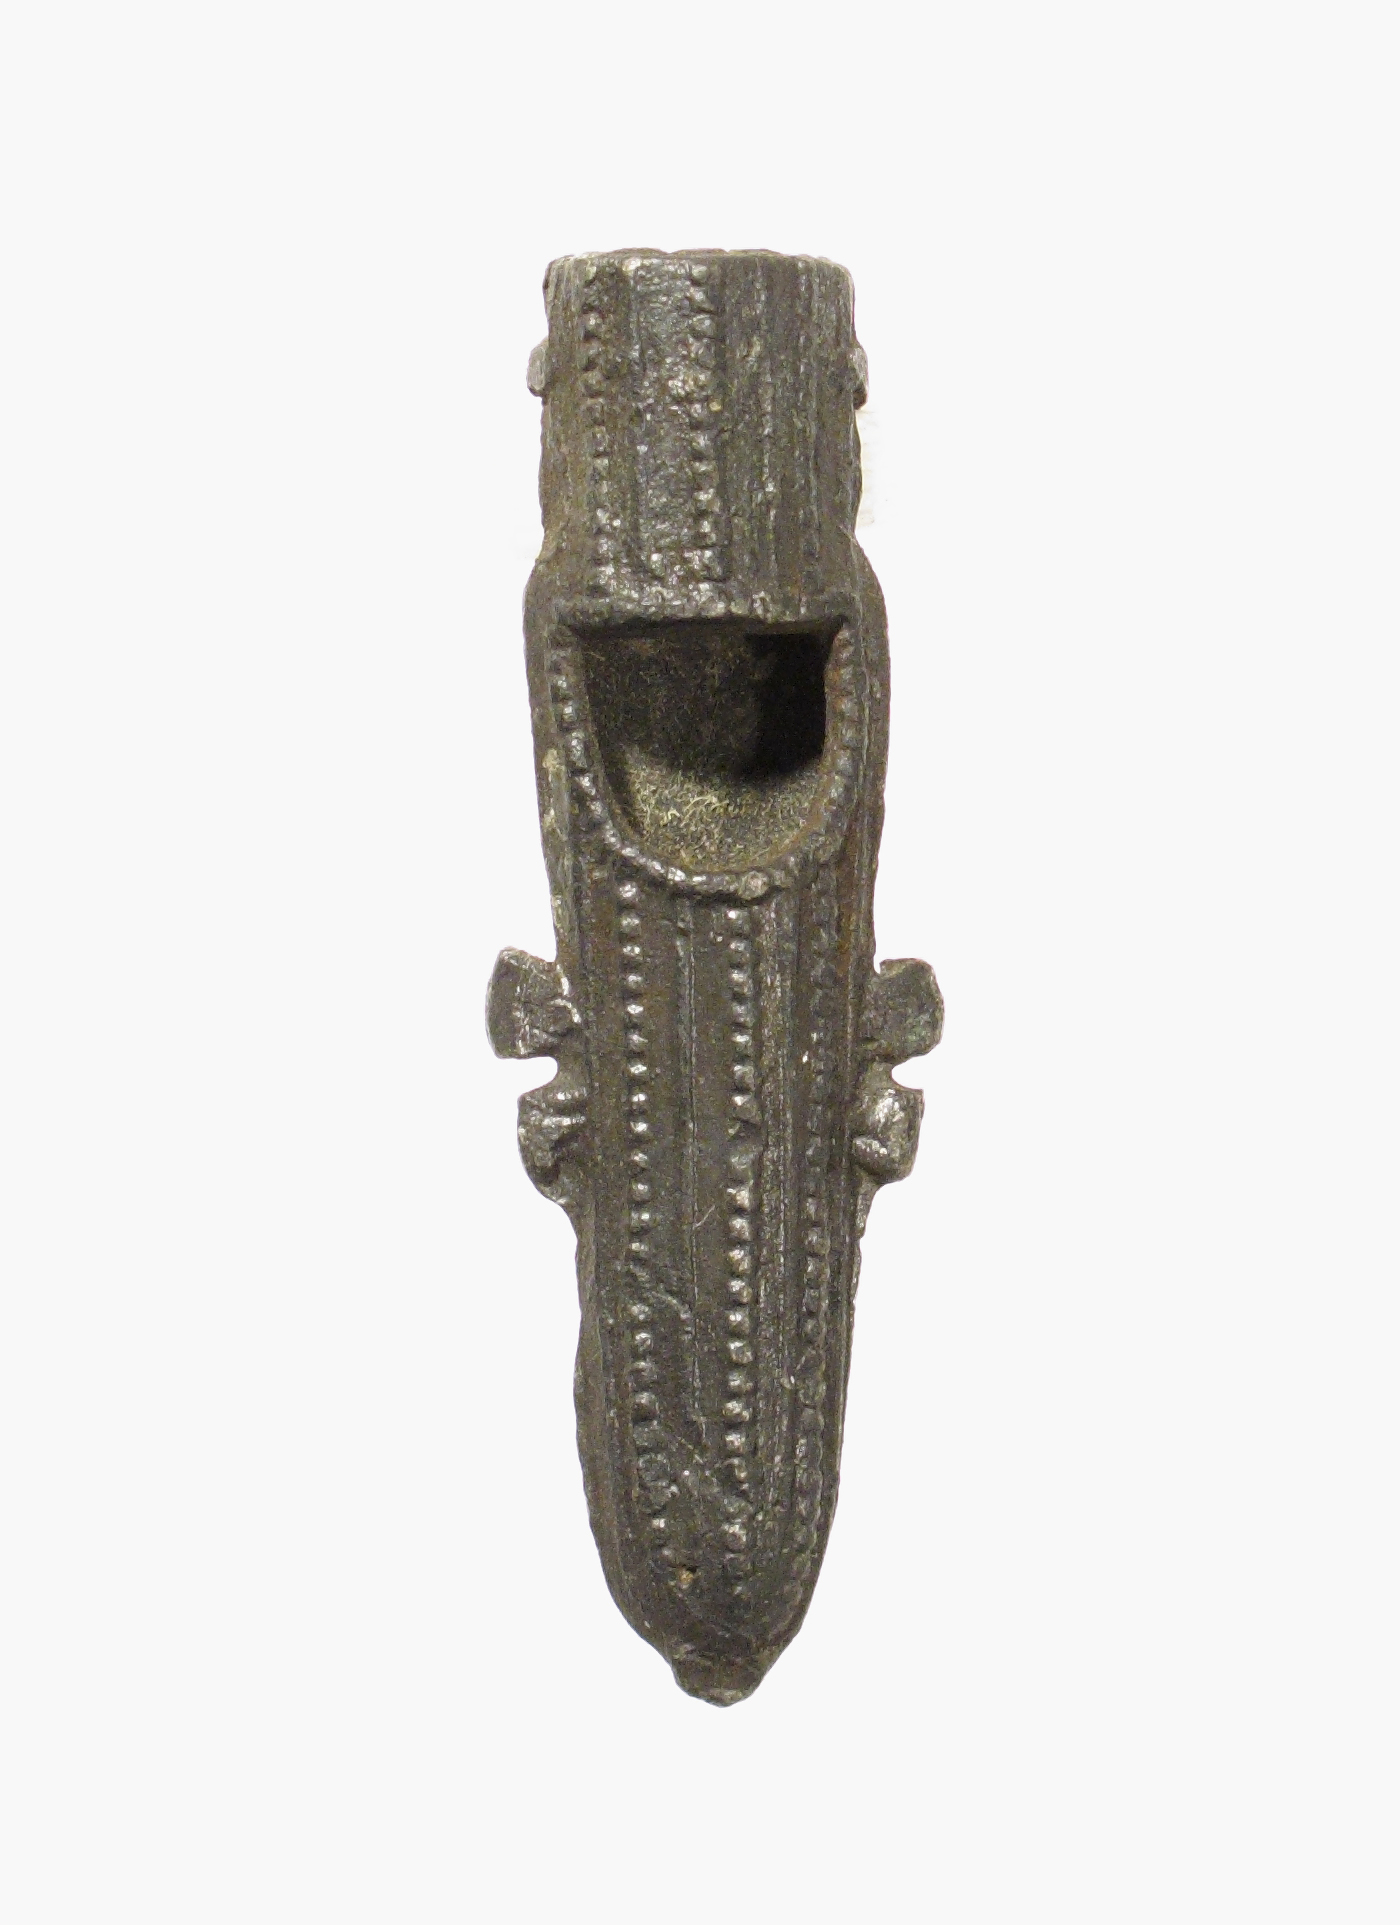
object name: pilgrim's badge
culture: french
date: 1401-1500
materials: lead